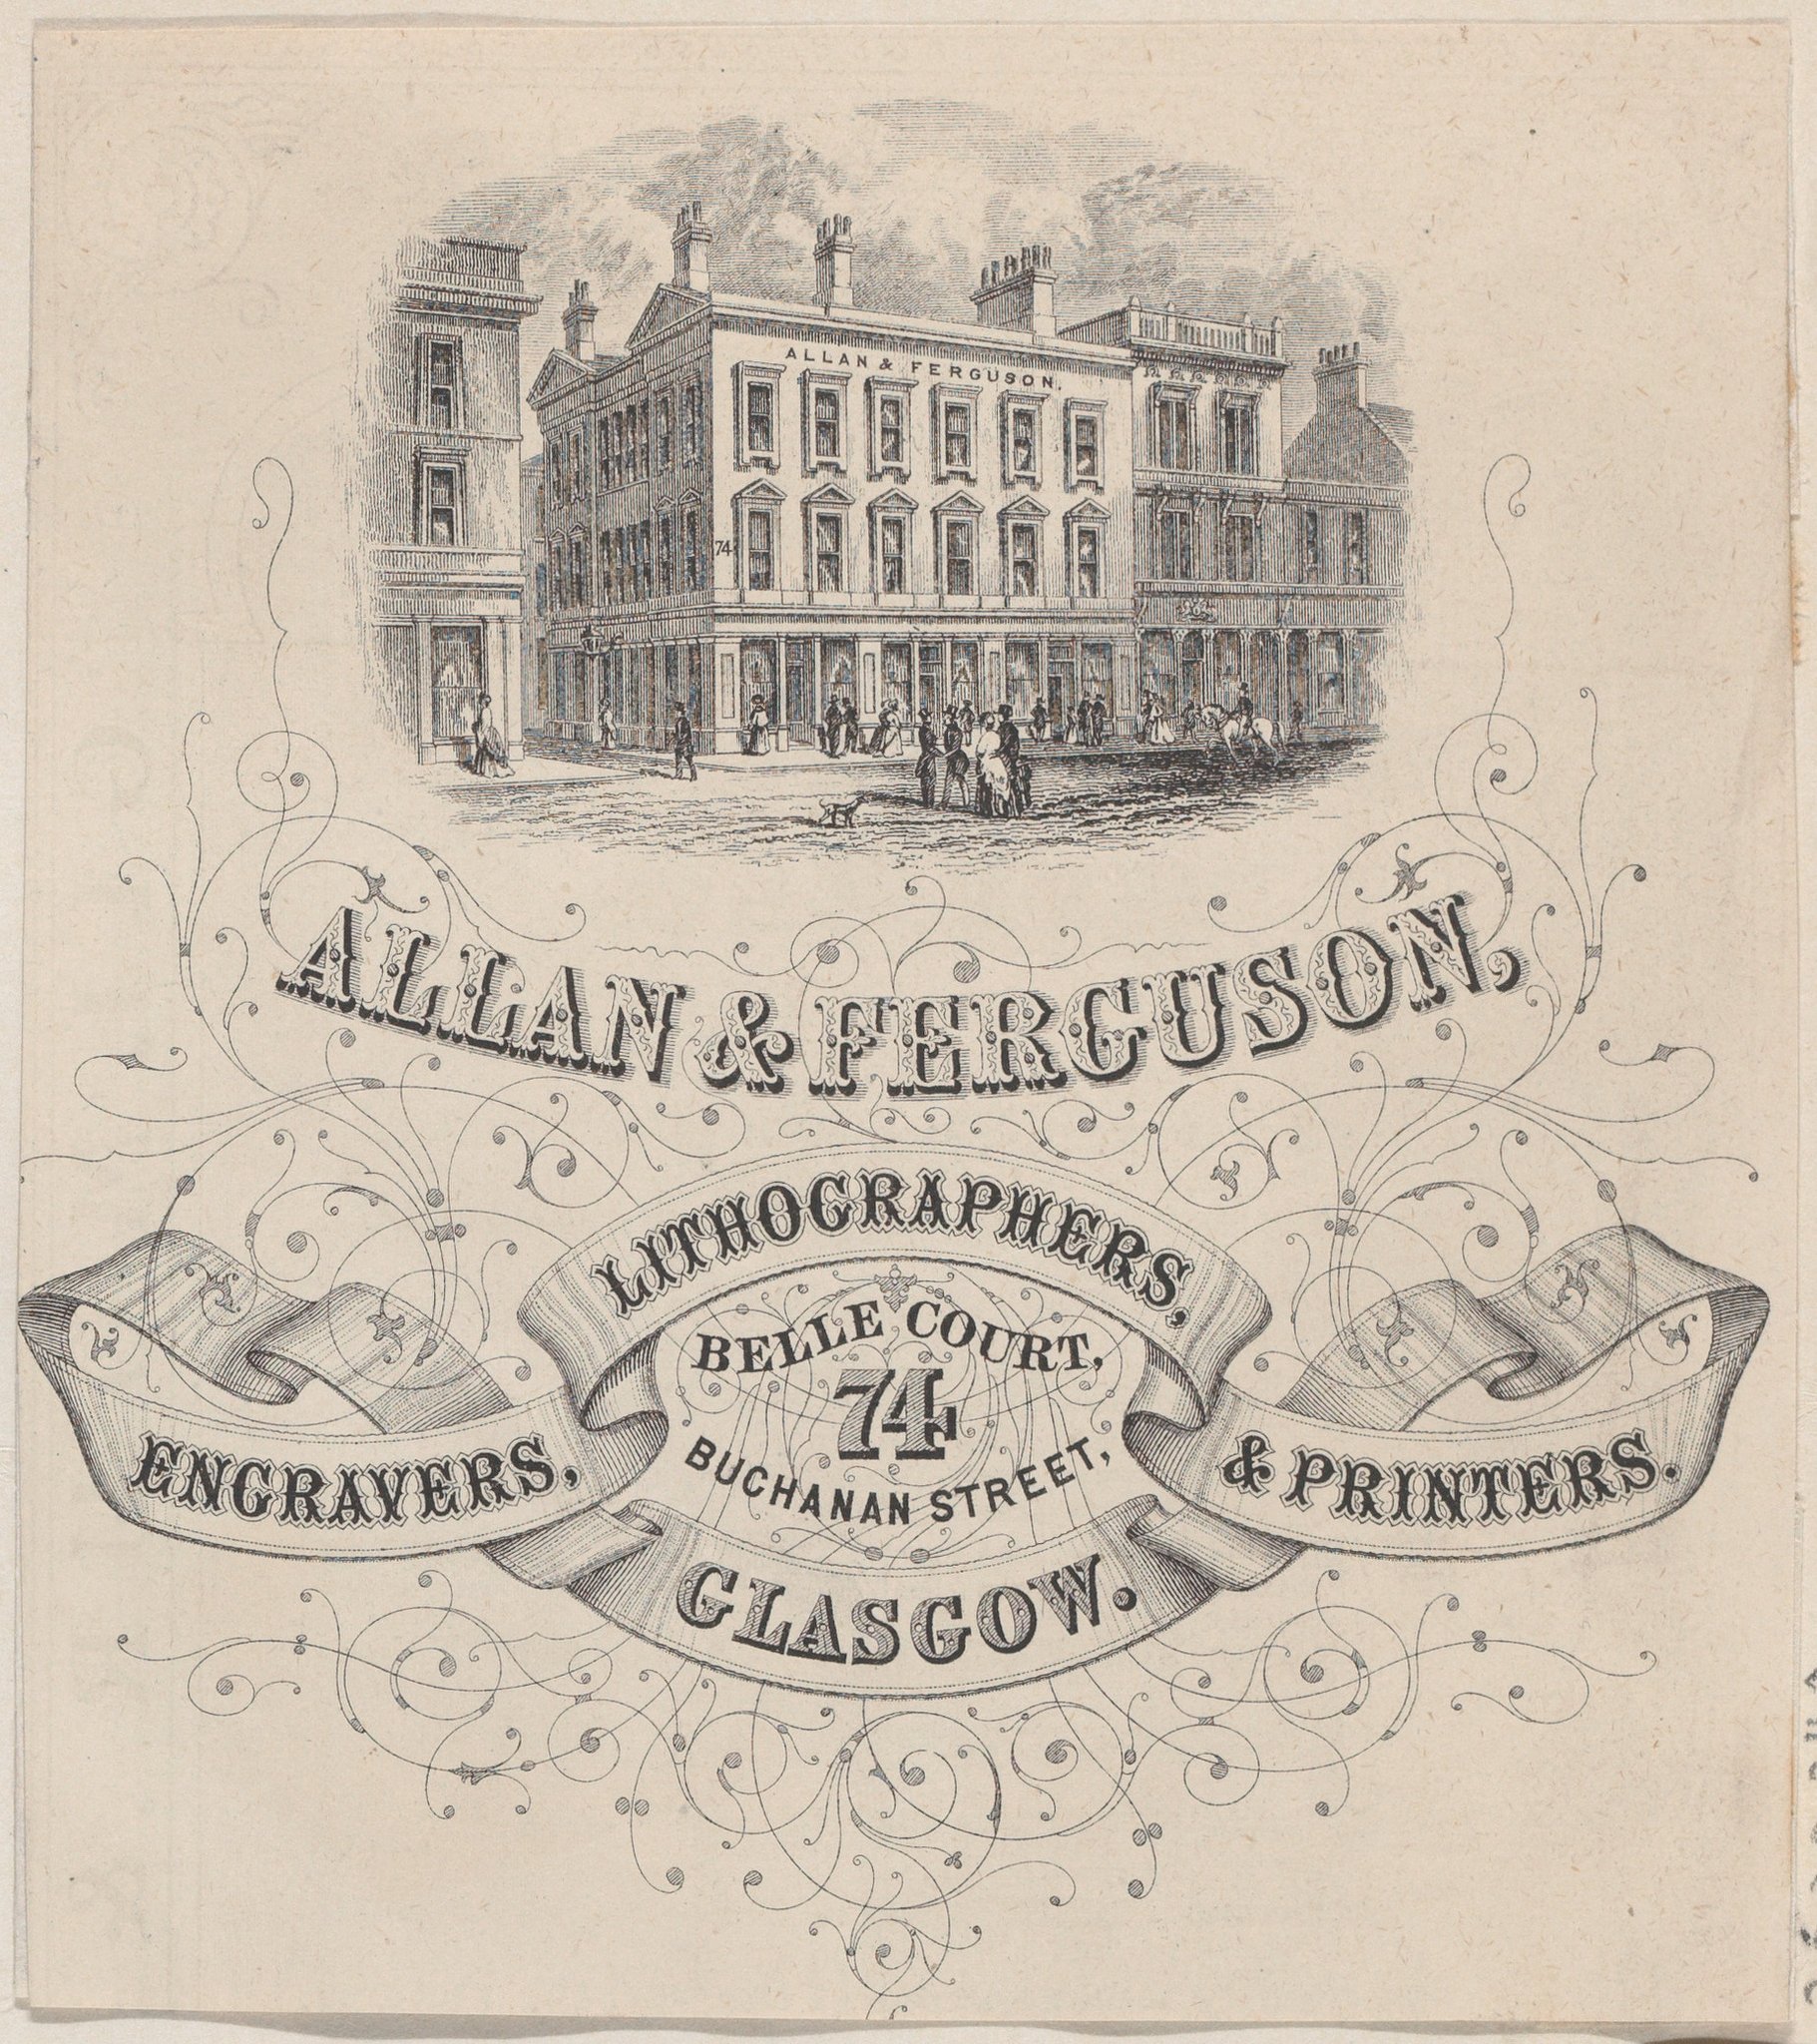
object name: print, trade card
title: Trade Card for Allan & Ferguson, Engravers, Lithographers & Printers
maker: anonymous, british, 19th century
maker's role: artist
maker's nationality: british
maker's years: 1800-1900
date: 1801-1900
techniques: lithography